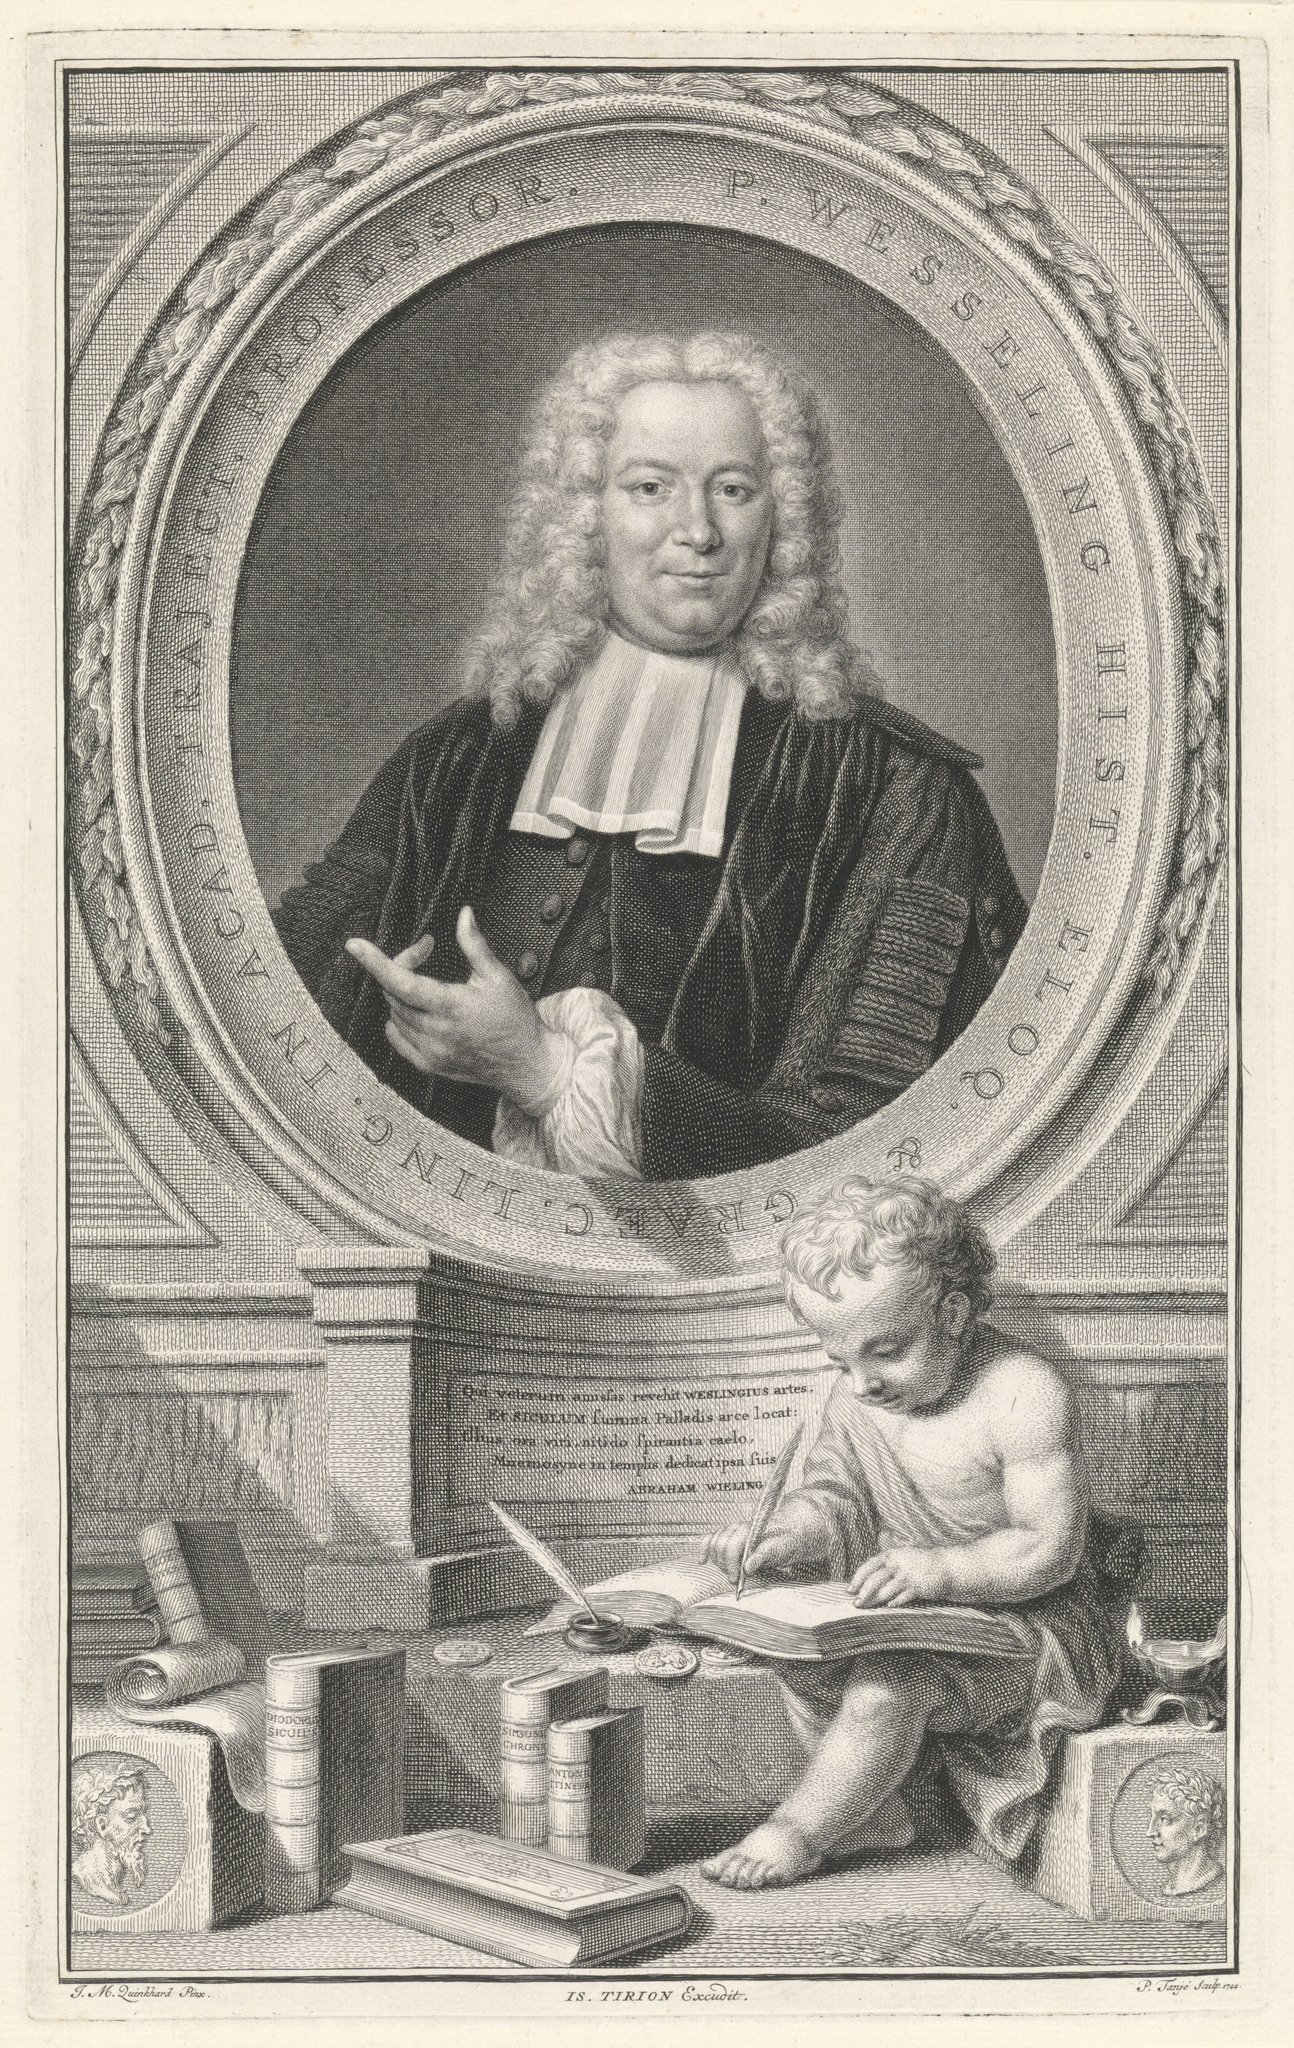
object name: print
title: Portret van Petrus Wesseling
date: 1744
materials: paper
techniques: engraving, etching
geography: amsterdam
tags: writing tools, book, cupids: 'amores', 'amoretti', 'putti'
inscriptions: collector's mark: Lugt 240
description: Portret van Petrus Wesseling, hoogleraar in de welsprekendheid, geschiedenis en het Grieks te Utrecht. Onder zijn portret schrijft een in toga geklede putto met een schrijfveer in een boek. Rond de putto liggen boeken en reliëfs van klassieke wijsgeren.